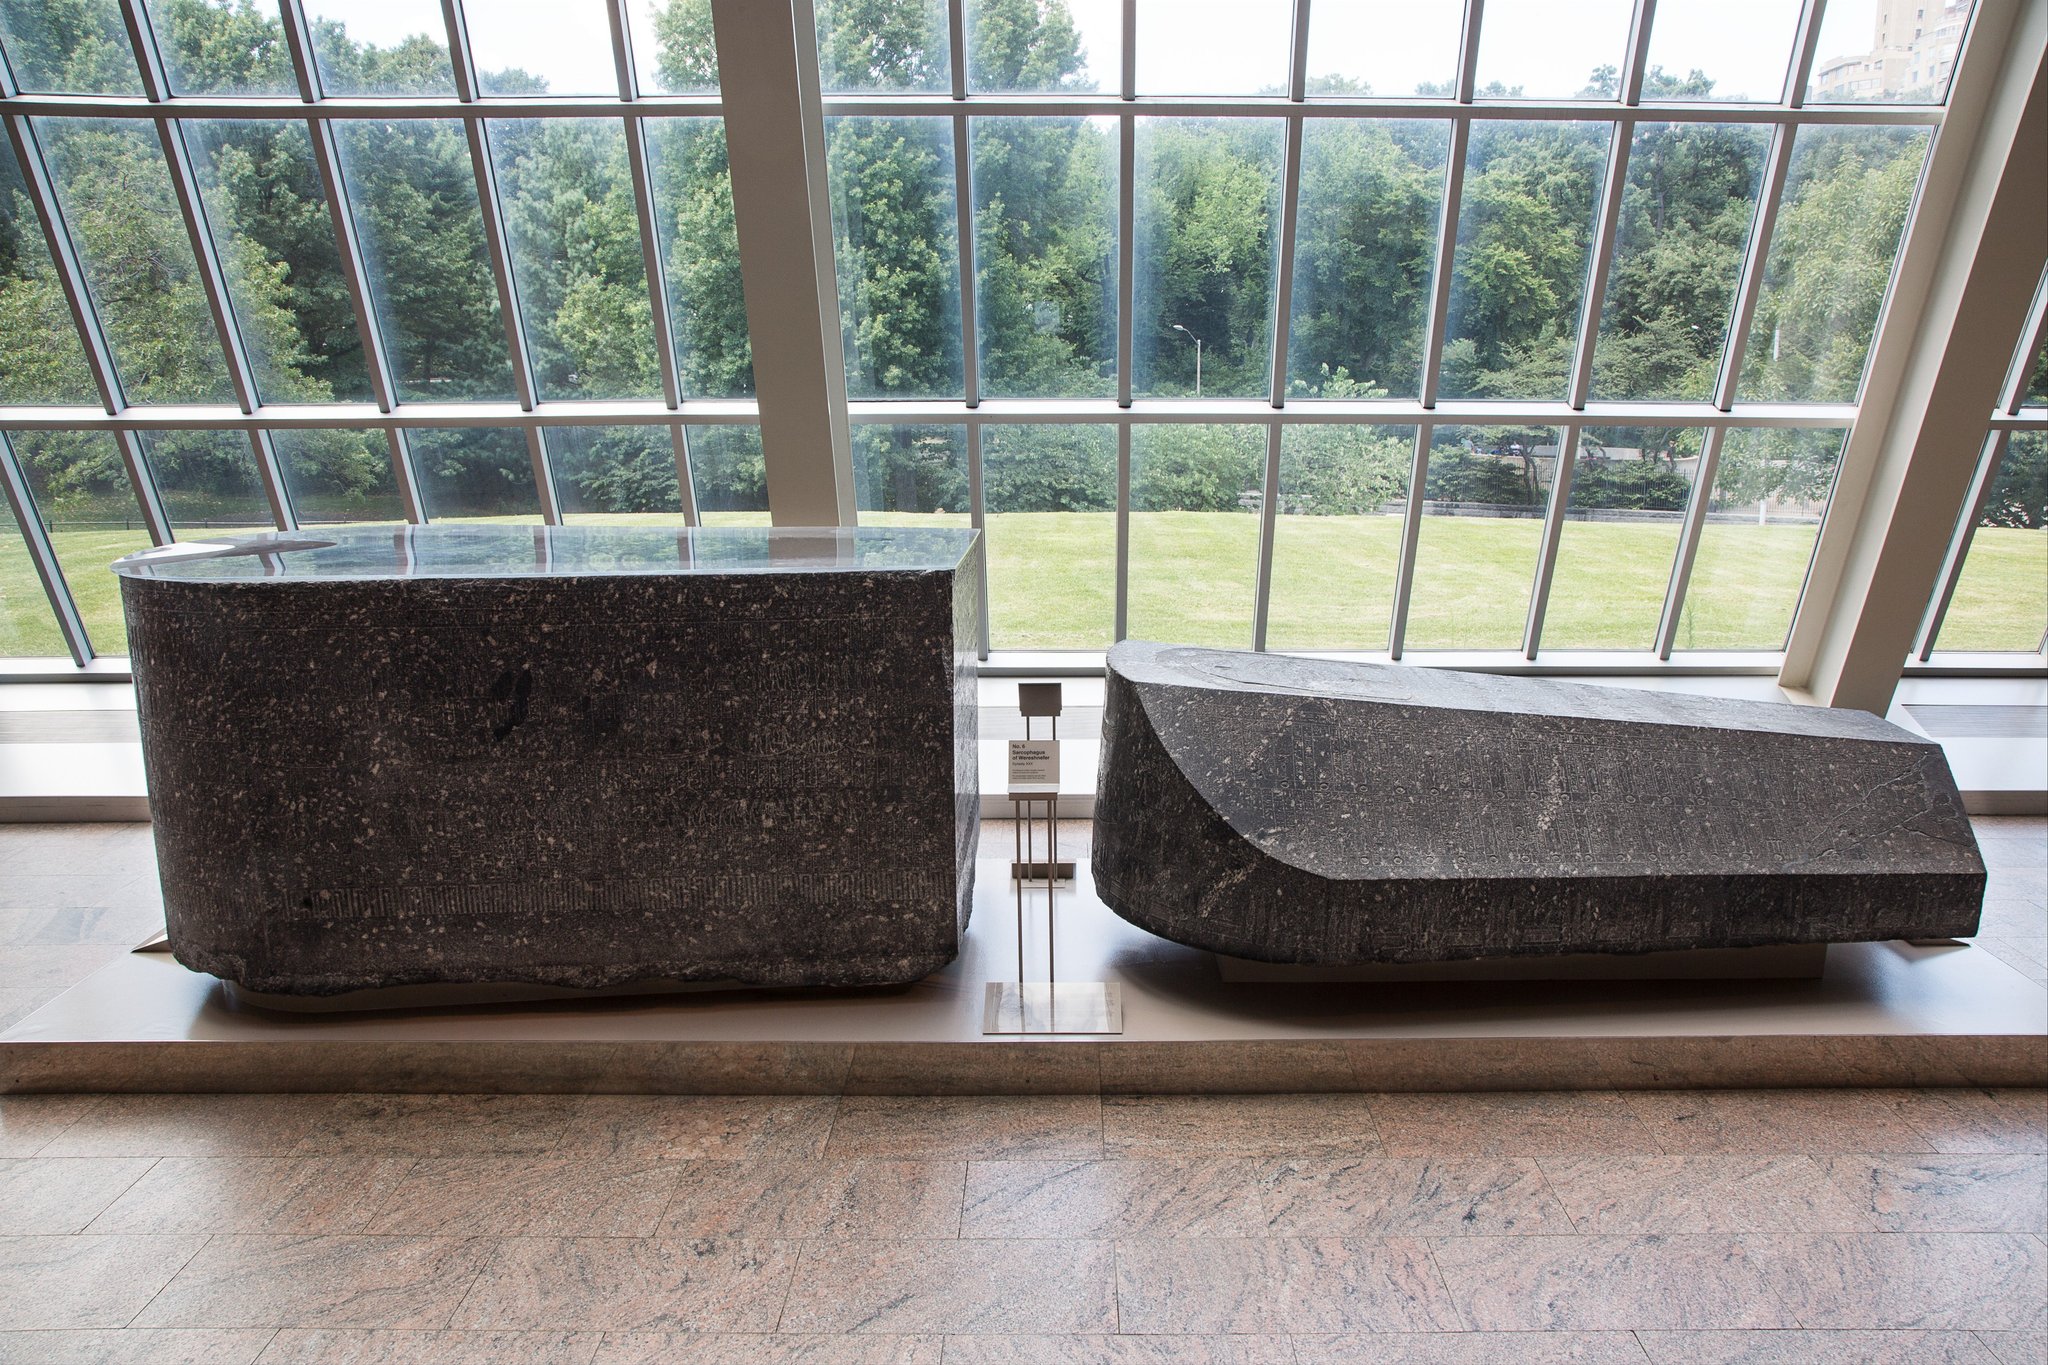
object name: sarcophagus, wereshnefer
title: Sarcophagus of Wereshnefer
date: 380-300 BCE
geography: egypt